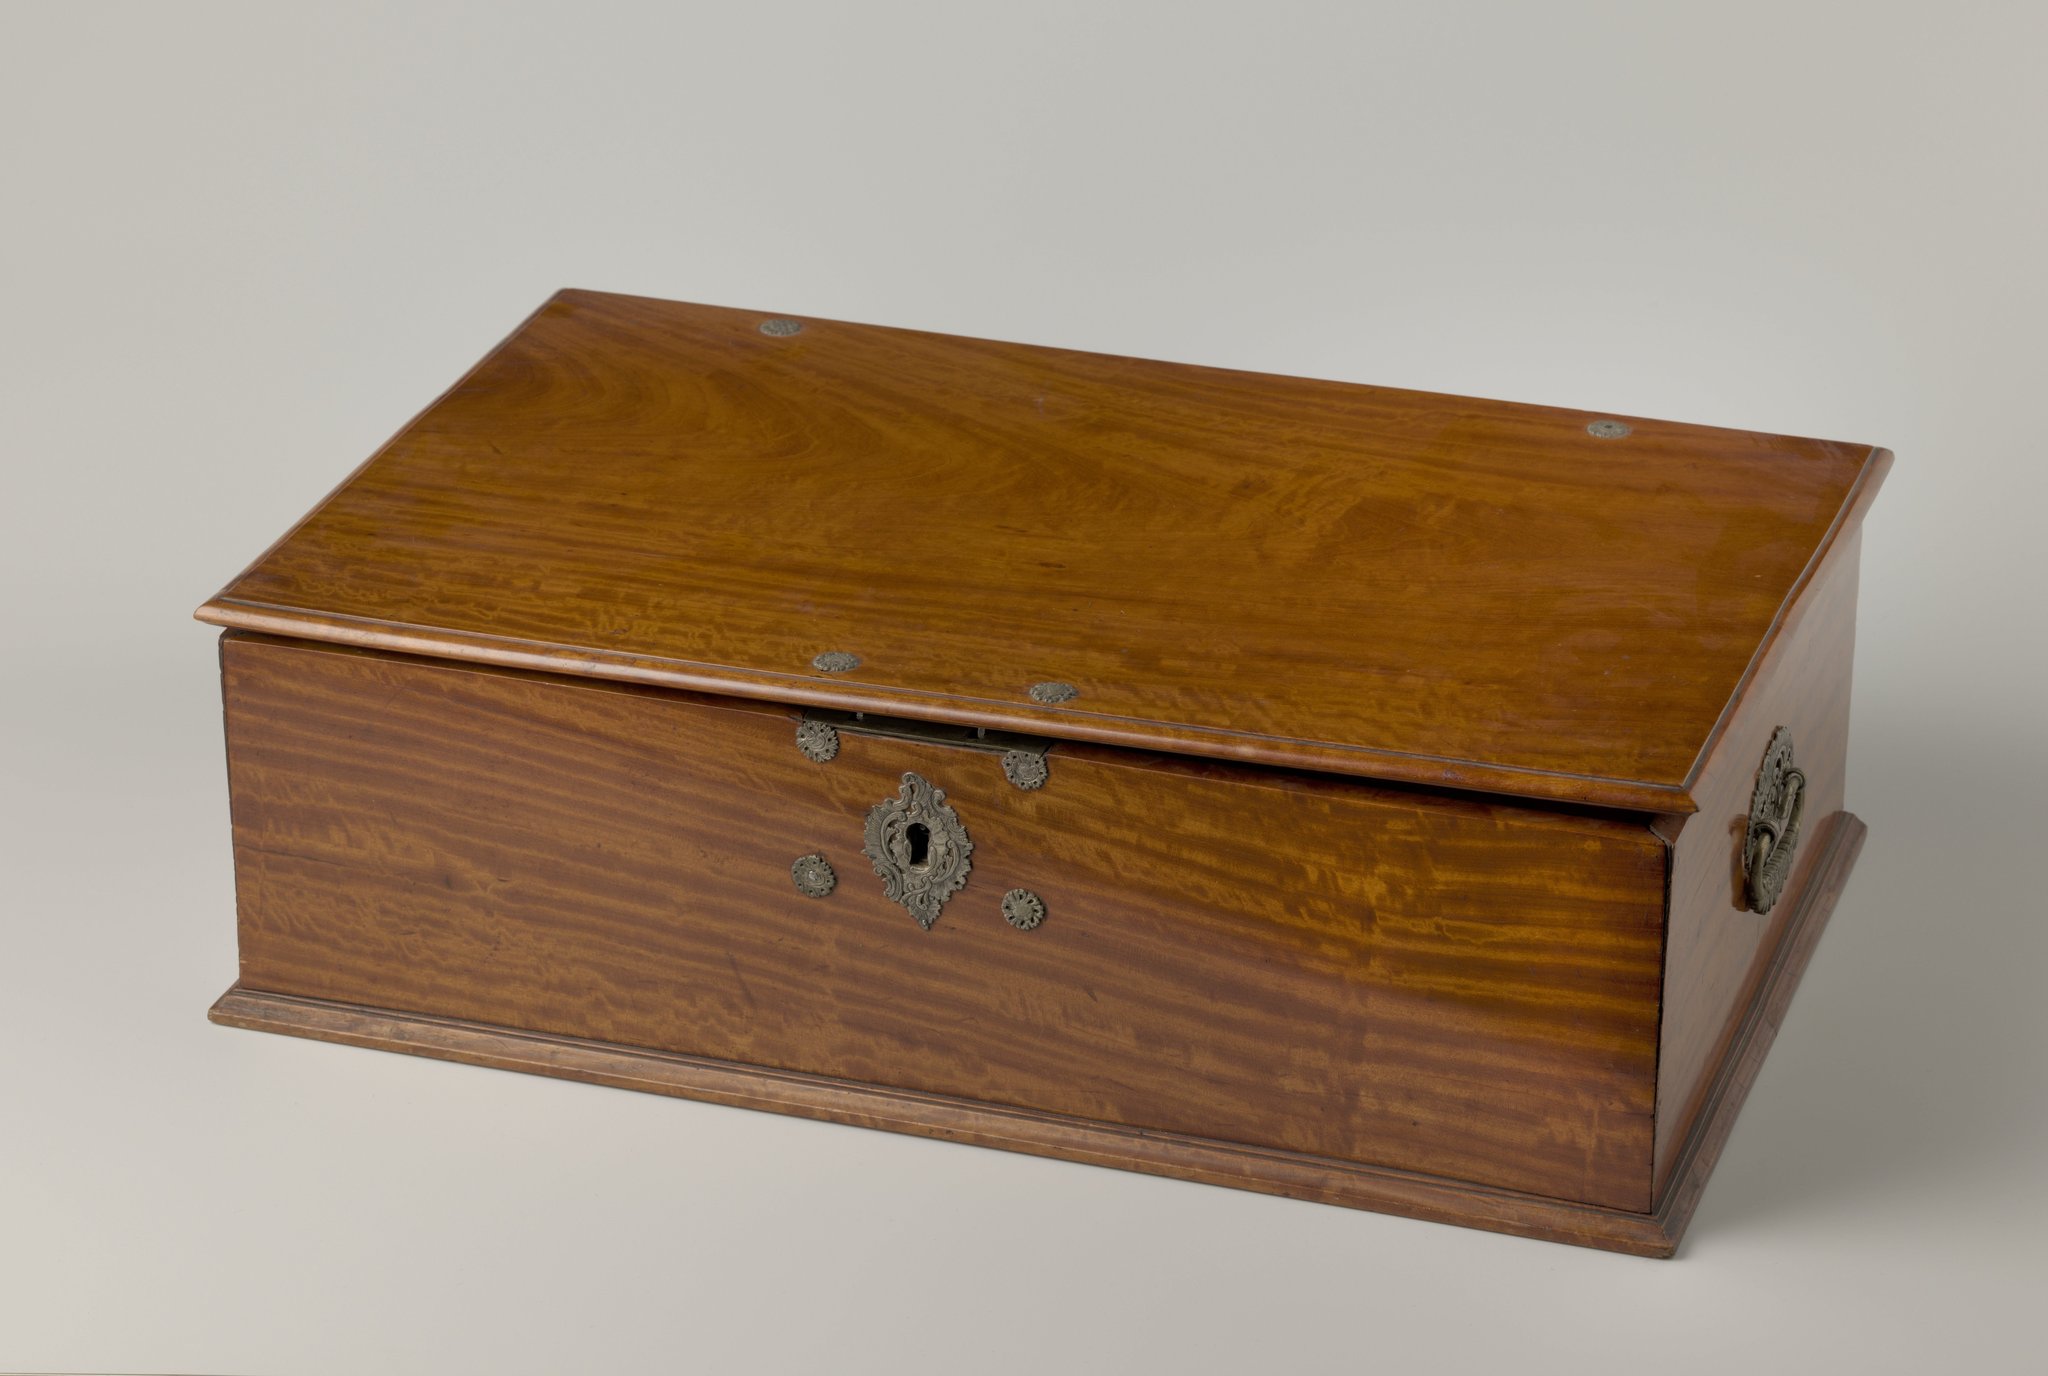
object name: schrijfkist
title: Schrijfkist met zilverbeslag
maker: Anonymous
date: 1750-1775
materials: wood, silver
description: Schrijfkist van satijnhout met geciseleerd, gegoten asymmetrisch beslag van zilver met rocailles, blad- en bloemwerk. In de kist zit een binnendoos met drie met deksels afsluitbare vakken.